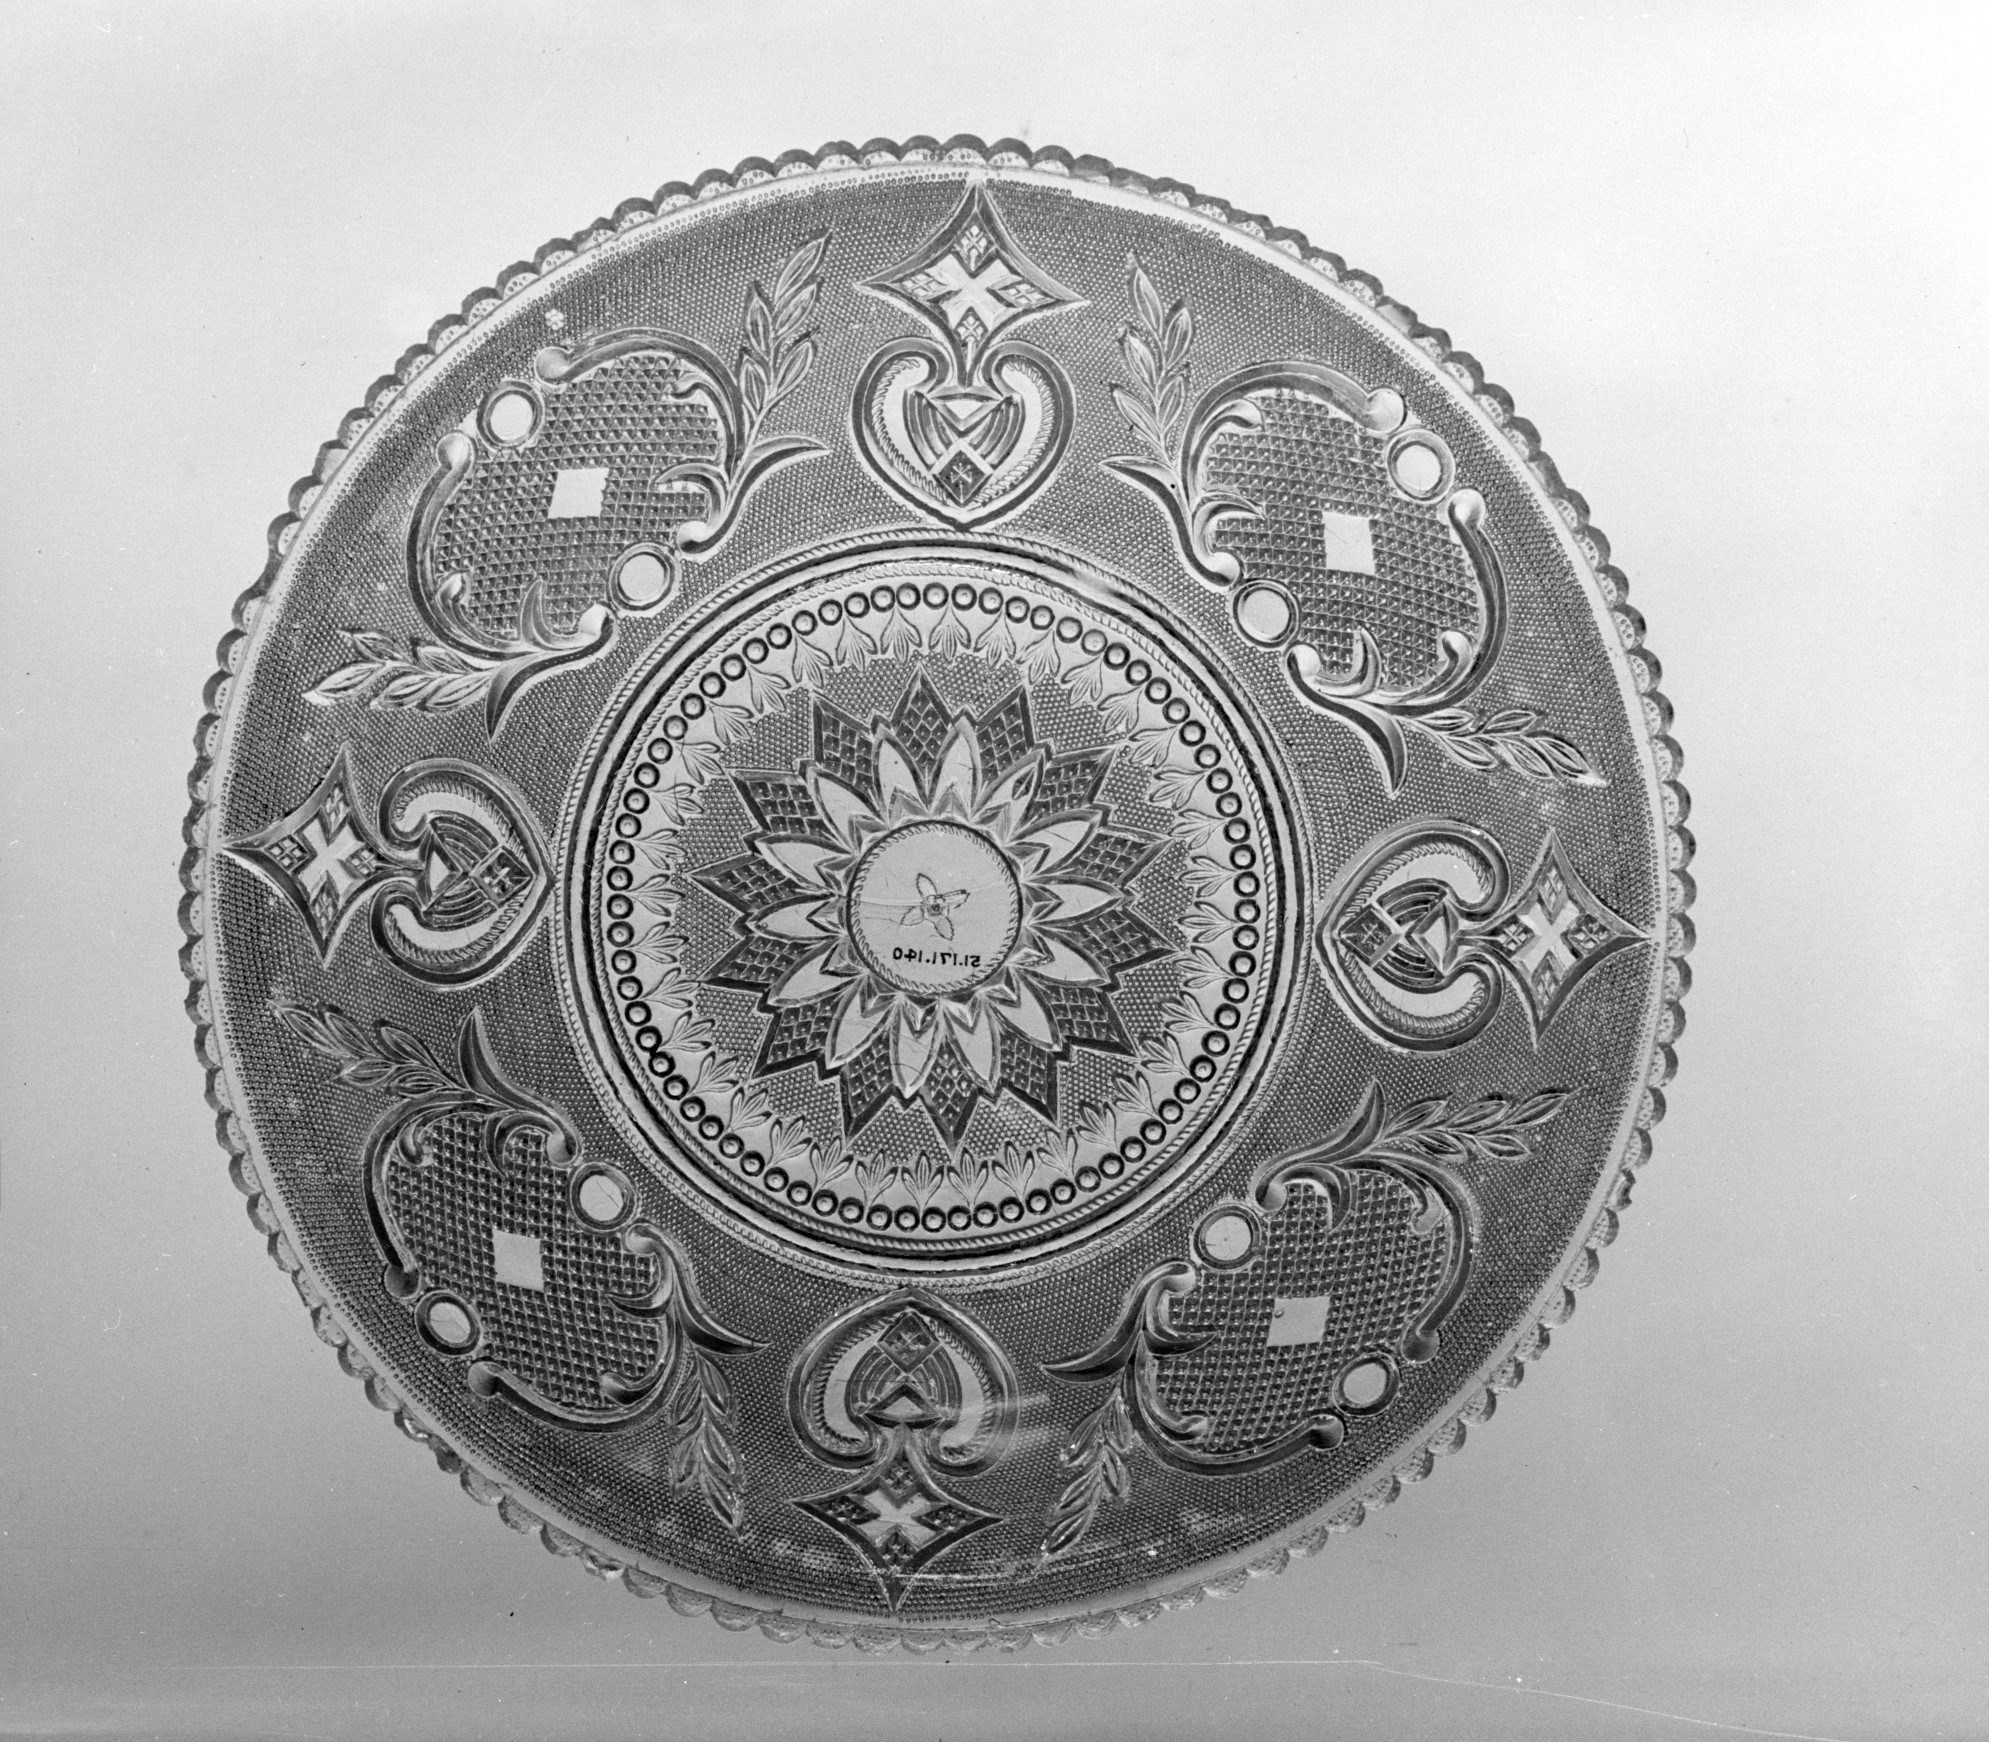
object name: bowl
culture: american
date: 1830-1845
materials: glass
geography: united states